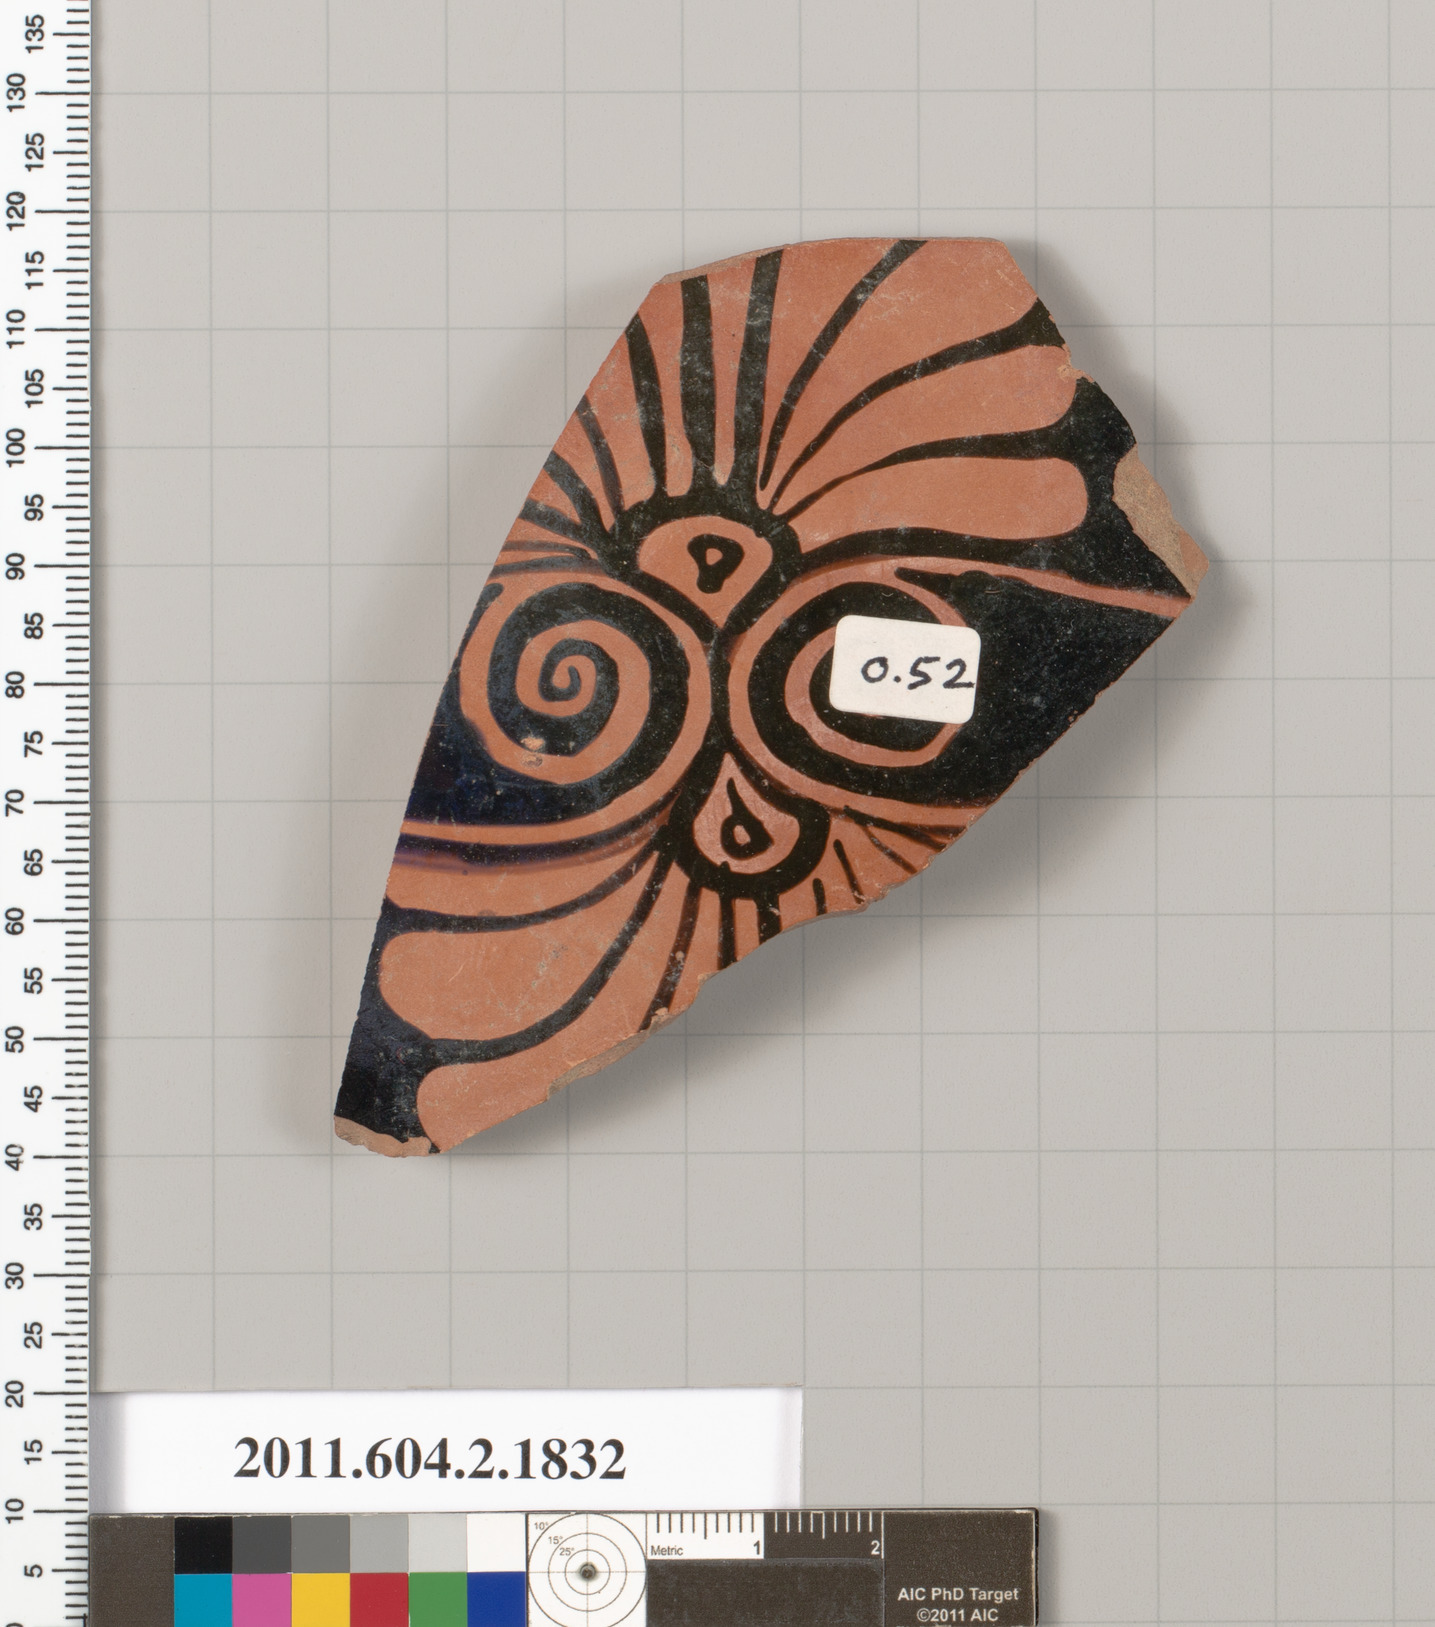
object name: skyphos fragment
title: Terracotta fragment of a skyphos (deep drinking cup)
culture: greek, attic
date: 440-420 BCE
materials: terracotta